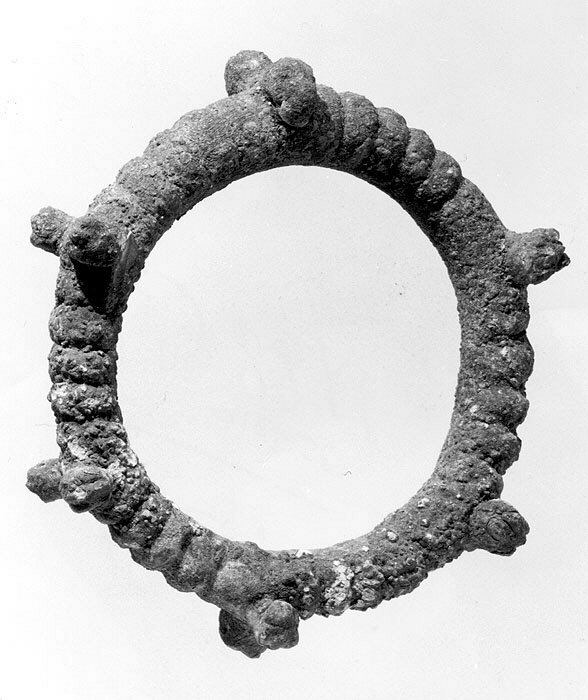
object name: bracelet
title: Bracelet with lion's-head terminals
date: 1000-668 BCE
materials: bronze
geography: transcaucasia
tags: lions